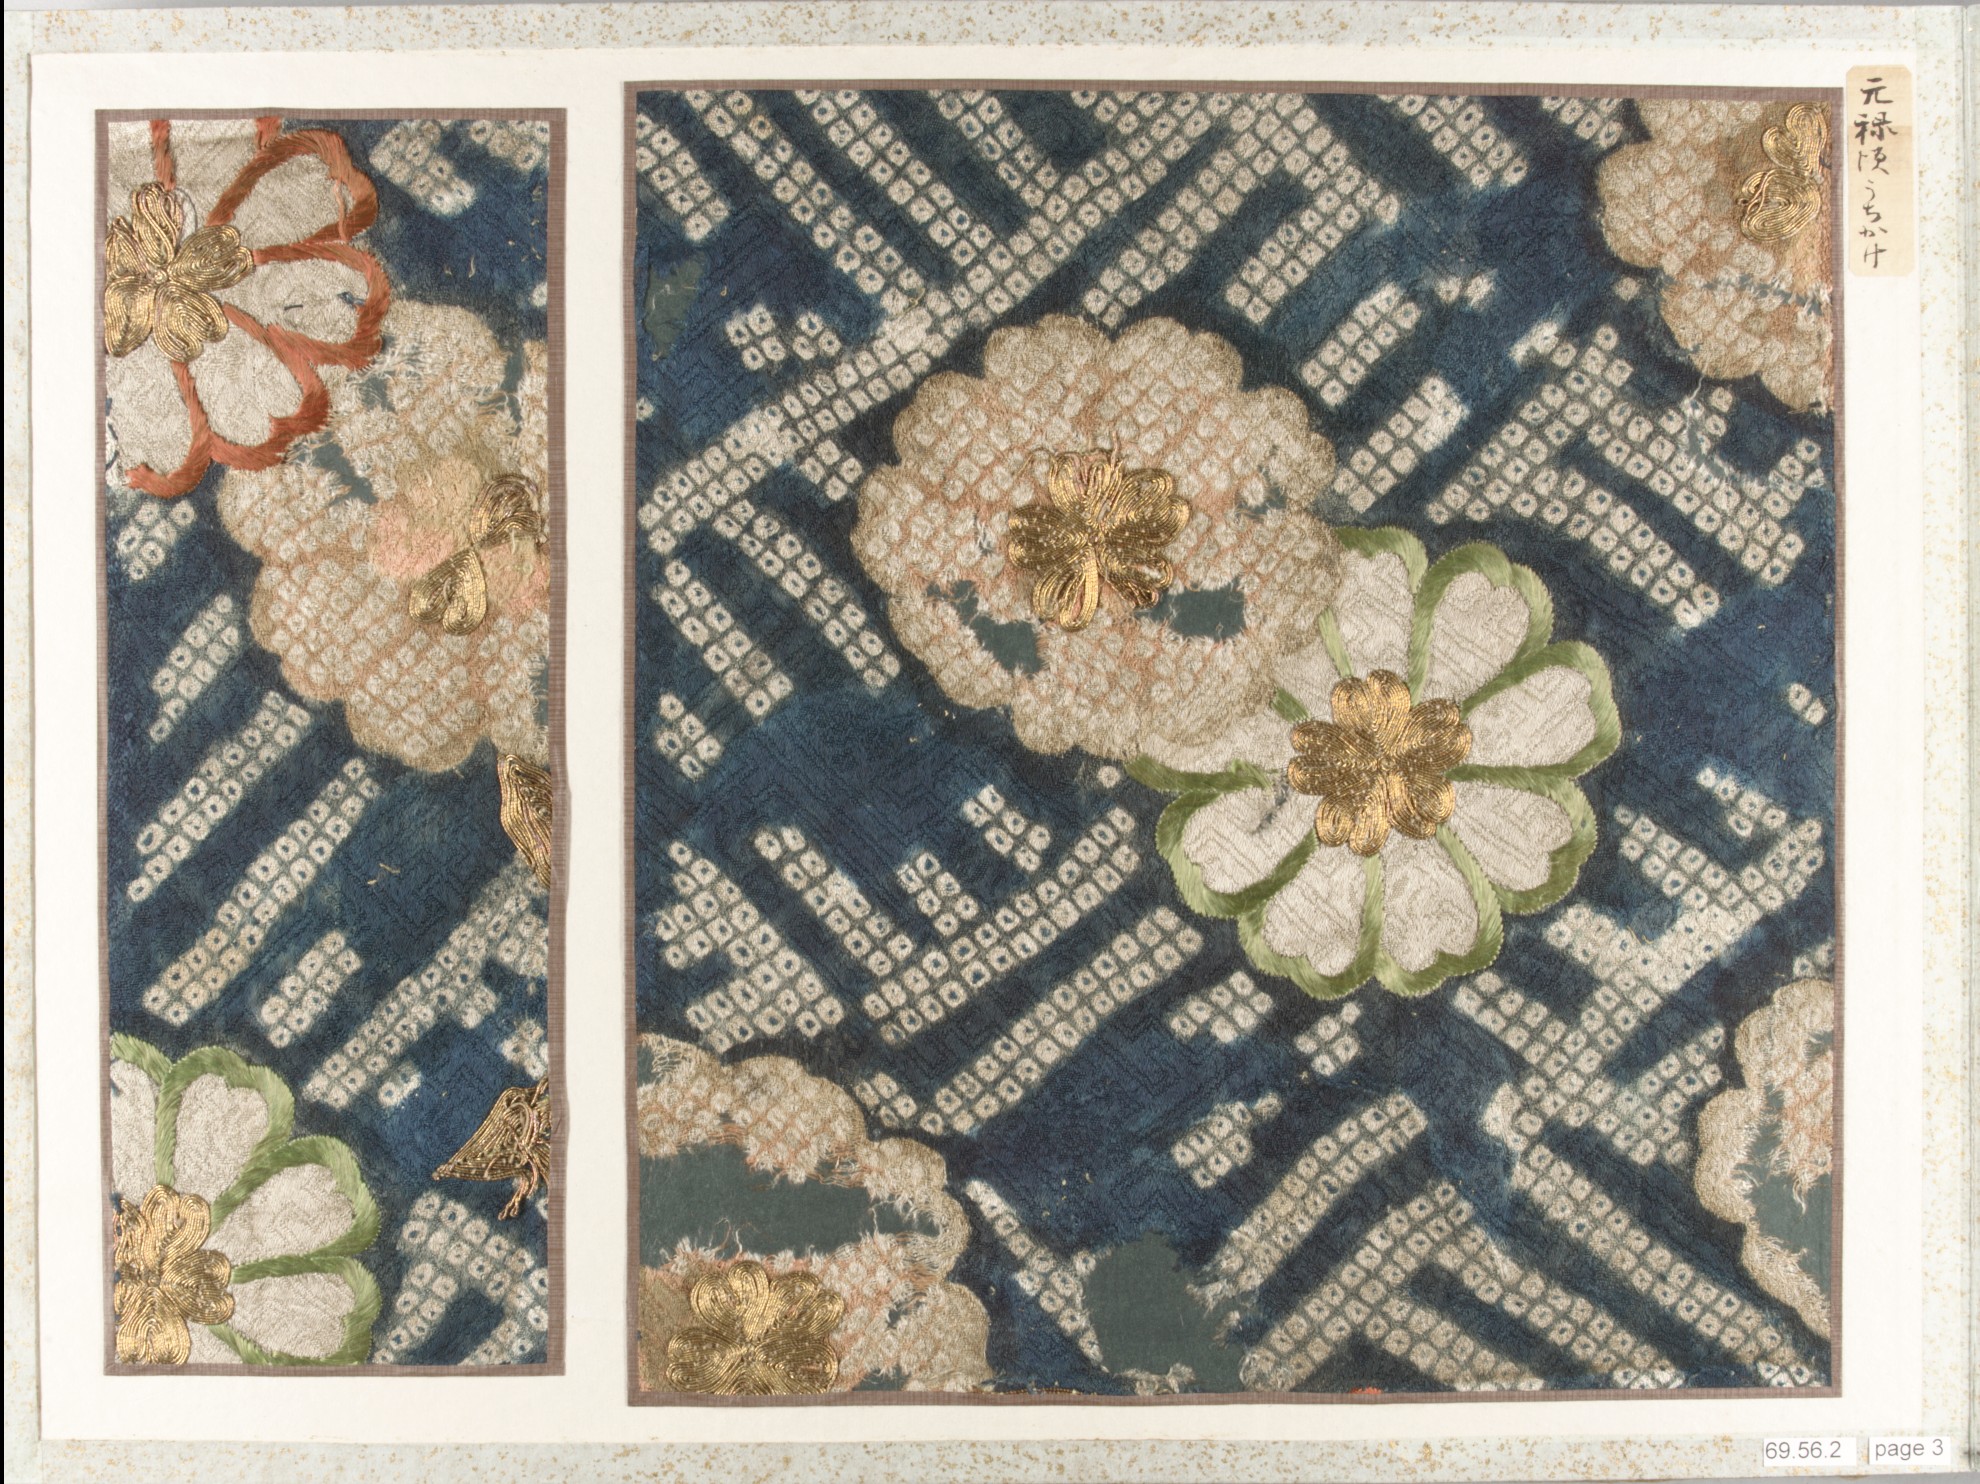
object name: book of silk fragment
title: Connoisseur's Book of Silk Fragments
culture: japanese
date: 1867-1900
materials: metal thread, silk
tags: flowers